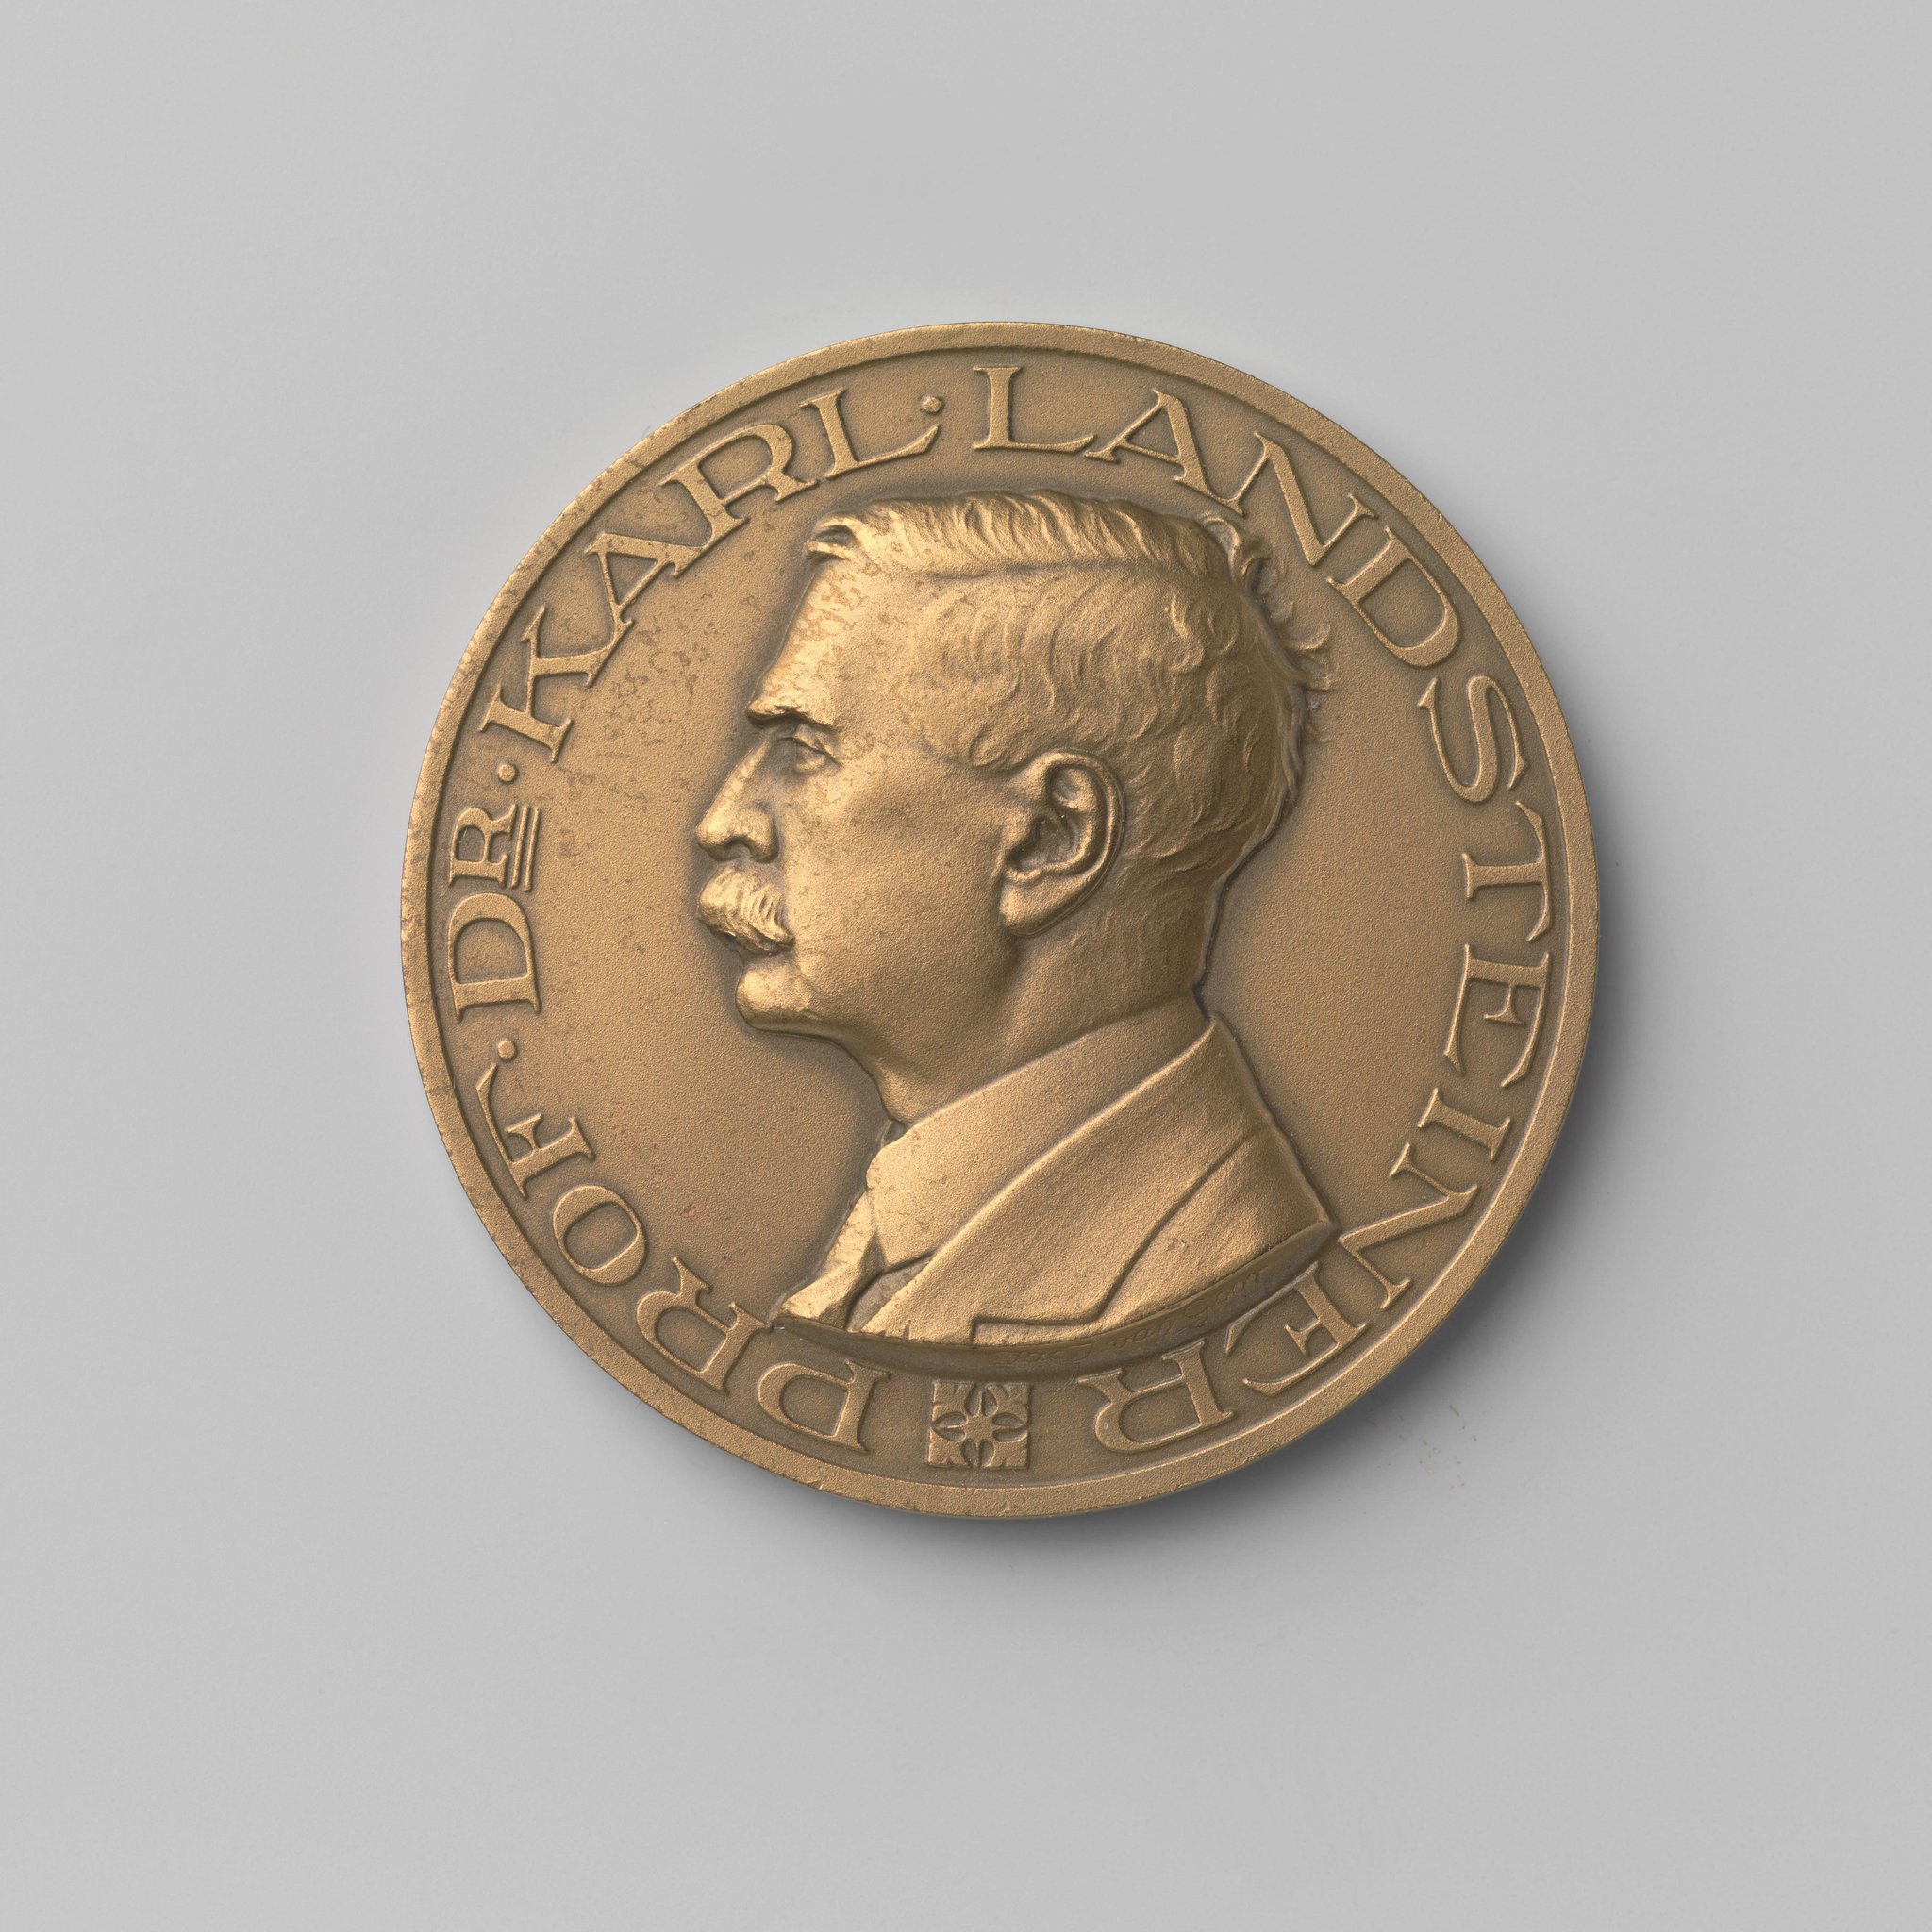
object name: history medal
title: Landsteiner-penning voor bloeddonatie bij de Bloedtransfusiedienst van het Roode Kruis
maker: jacob jan van goor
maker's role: medailleur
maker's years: 1874-1956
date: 1931-1944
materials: bronze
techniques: striking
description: Bronzxen penning, op de voorzijde het borstbeeld van Karl Landsteiner naar links met omschrift, op de keerzijde een pelikaan met jongen op een nest met linksboven een kruis, met dubbel omschrift.